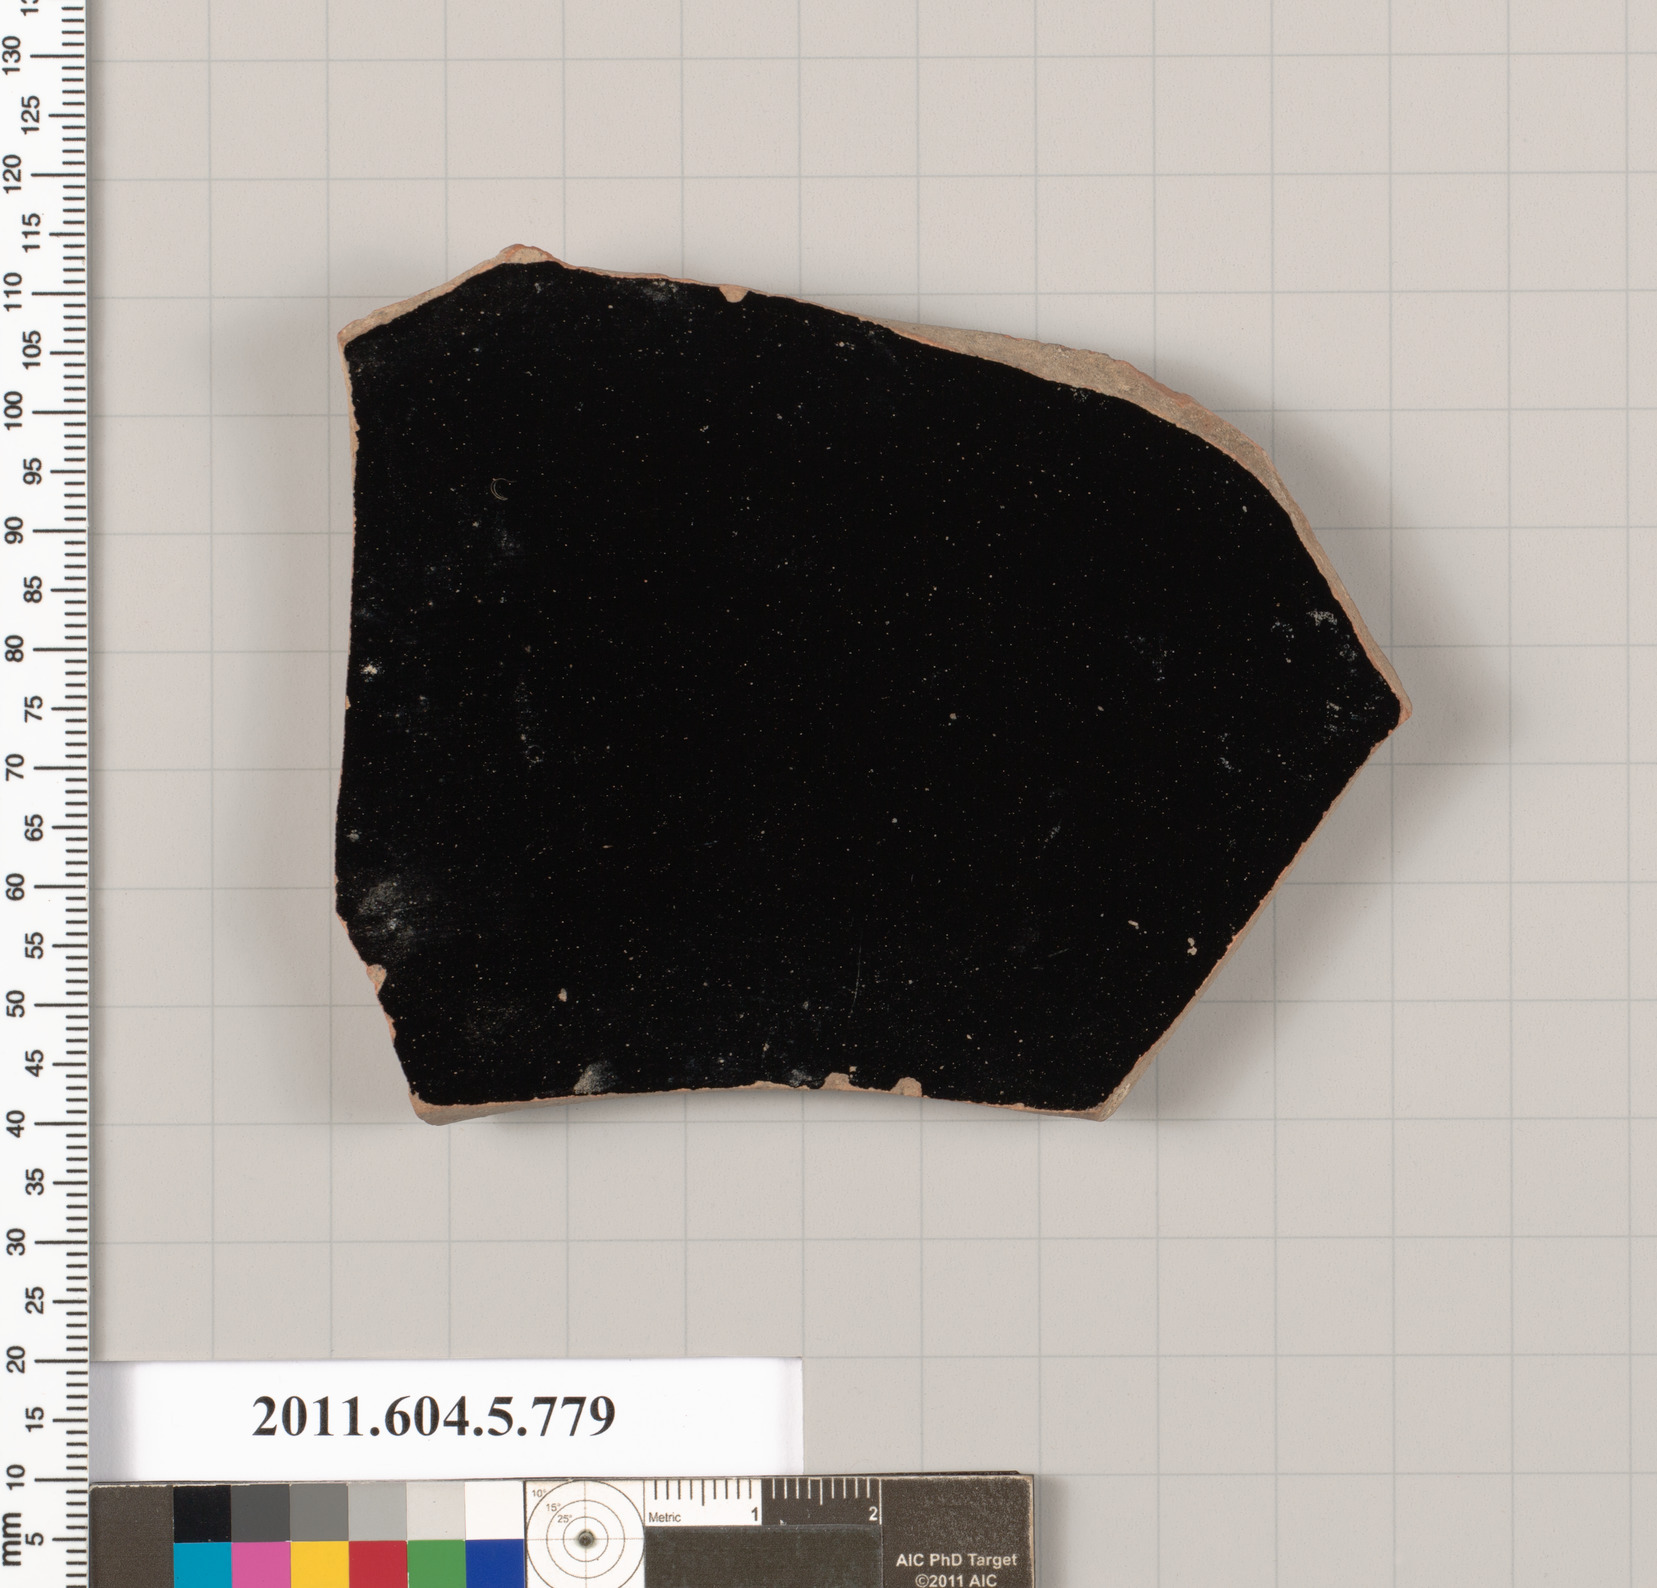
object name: kylix fragment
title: Terracotta fragment of a kylix (drinking cup)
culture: greek, attic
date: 600-401 BCE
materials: terracotta